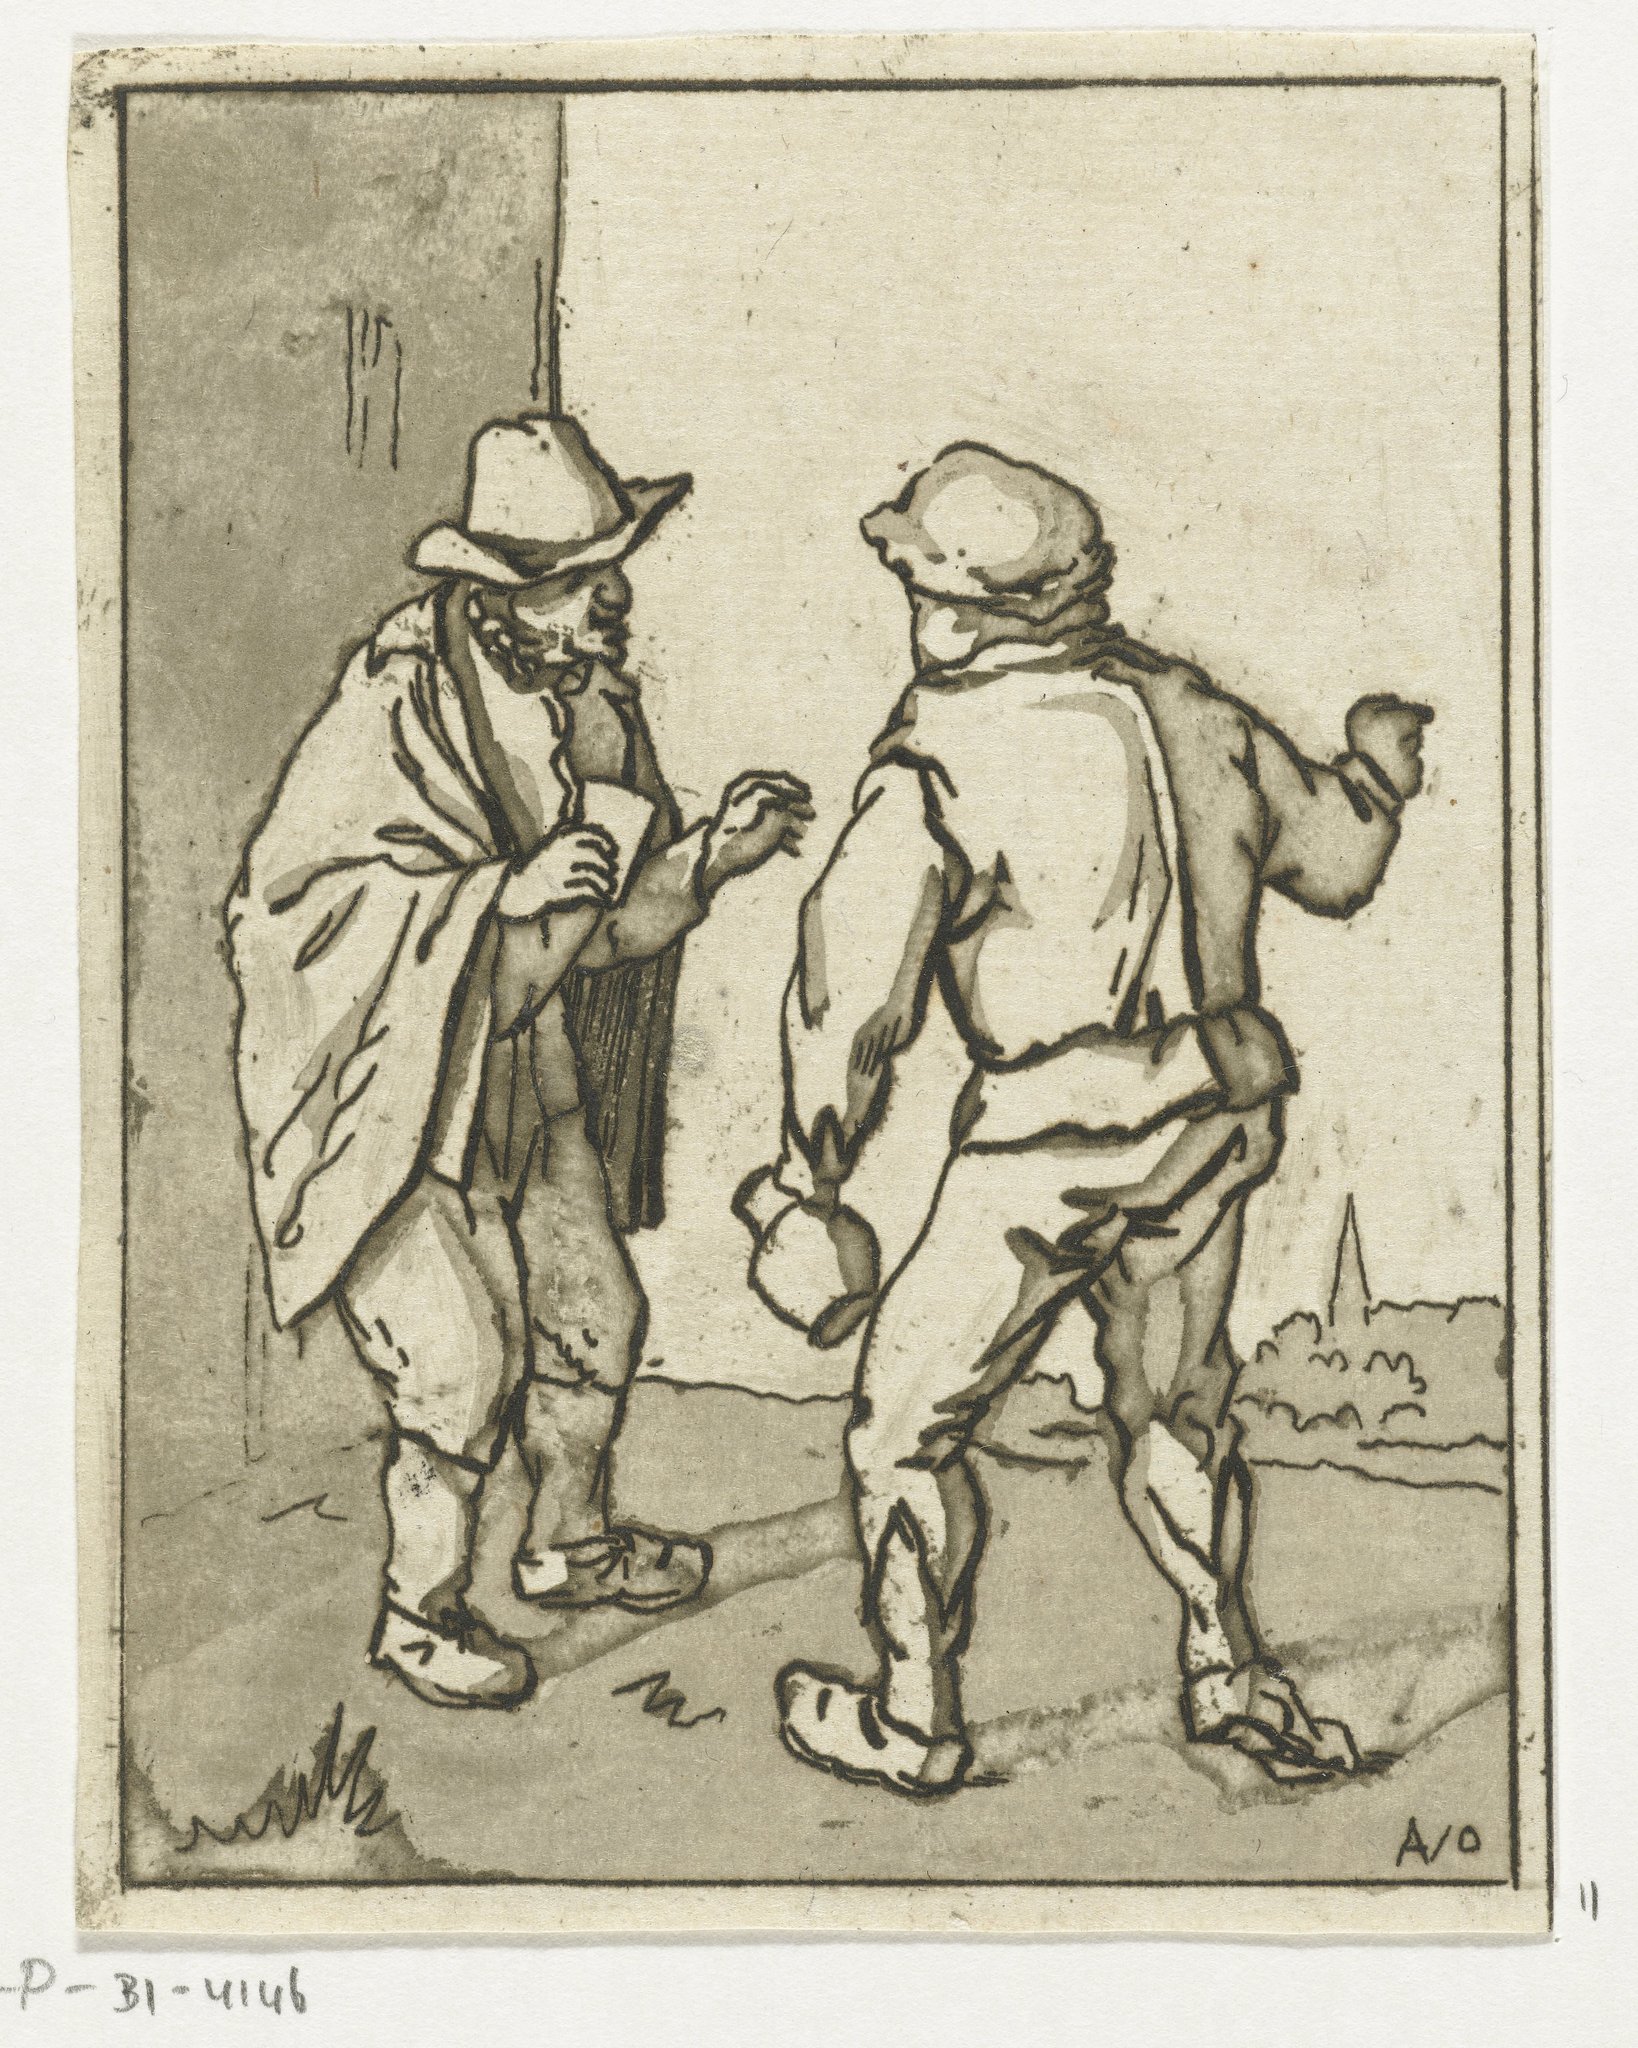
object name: print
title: Twee staande mannen in gesprek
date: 1778-1838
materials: paper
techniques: aquatint, etching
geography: netherlands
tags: meeting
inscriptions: collector's mark: Lugt 2228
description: Twee mannen ontmoeten elkaar op de weg. De een houdt een kruik in zijn hand. Hij wijst de ander de weg.